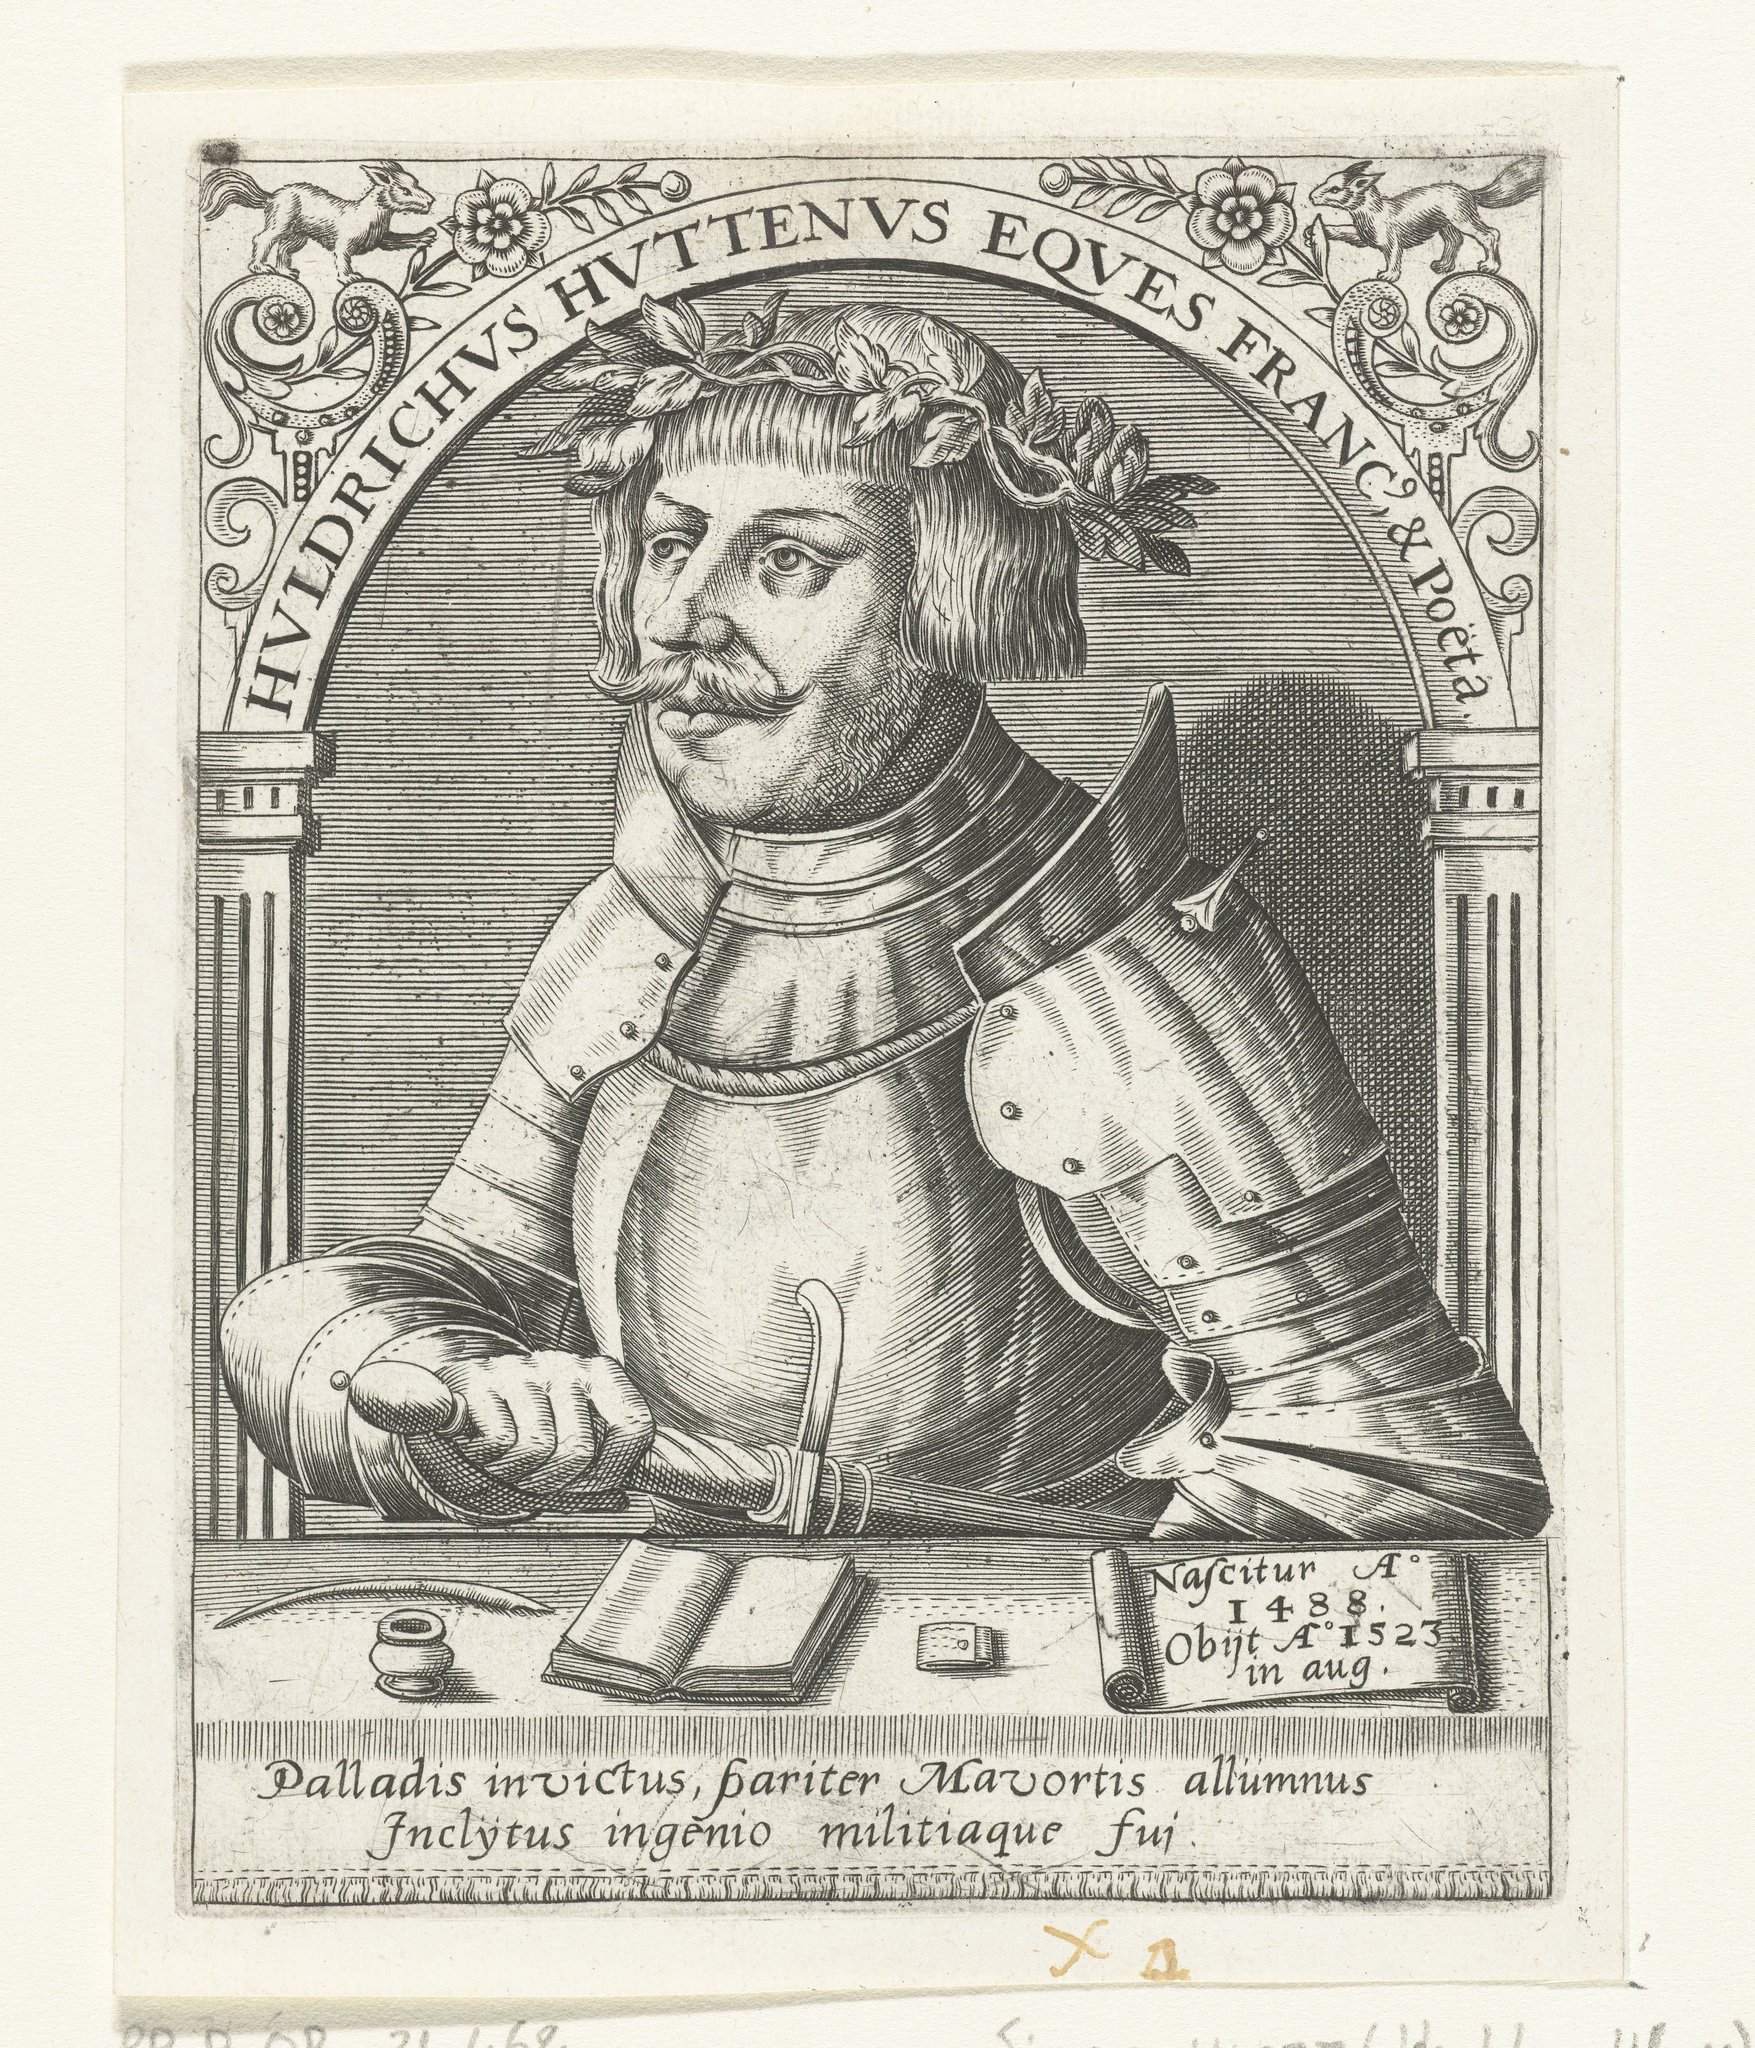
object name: book illustration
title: Portret van Ulrich von Hutten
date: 1597-1599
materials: paper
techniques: engraving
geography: frankfurt am main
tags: switzerland, politician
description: Portret van de ridder Ulrich von Hutten met harnas en zwaard. Op tafel voor hem ligt een open boek en schrijfgerei. Onder het portret een Latijns vers.